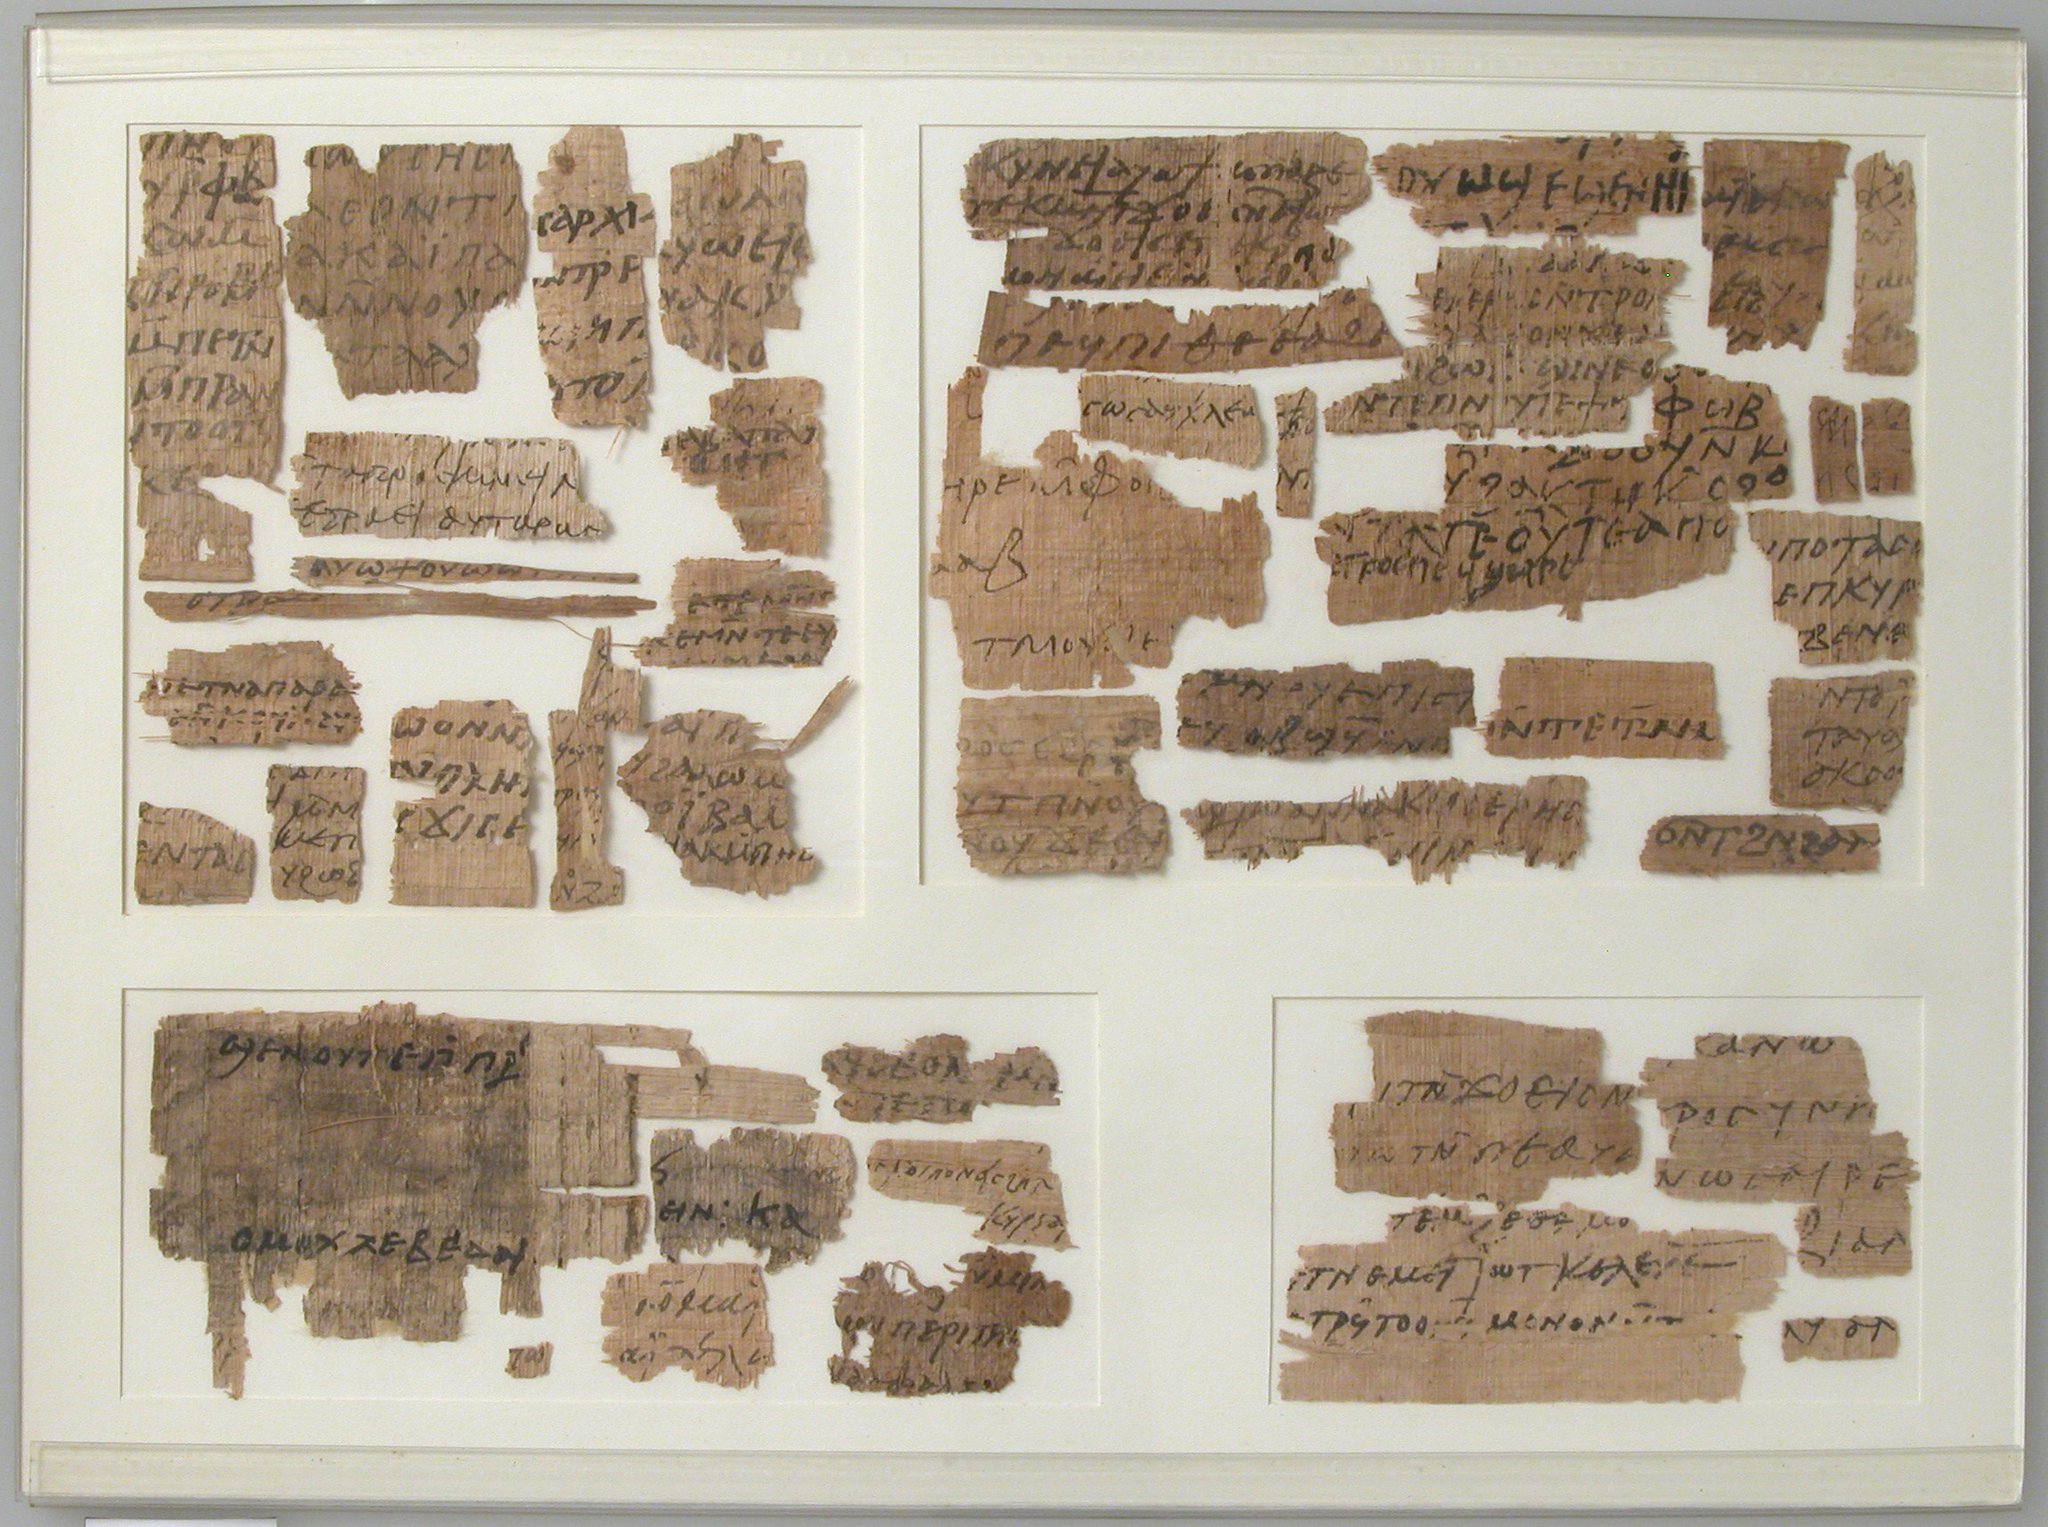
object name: fragment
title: Papyri Fragments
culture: coptic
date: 601-700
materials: ink, papyrus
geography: egypt